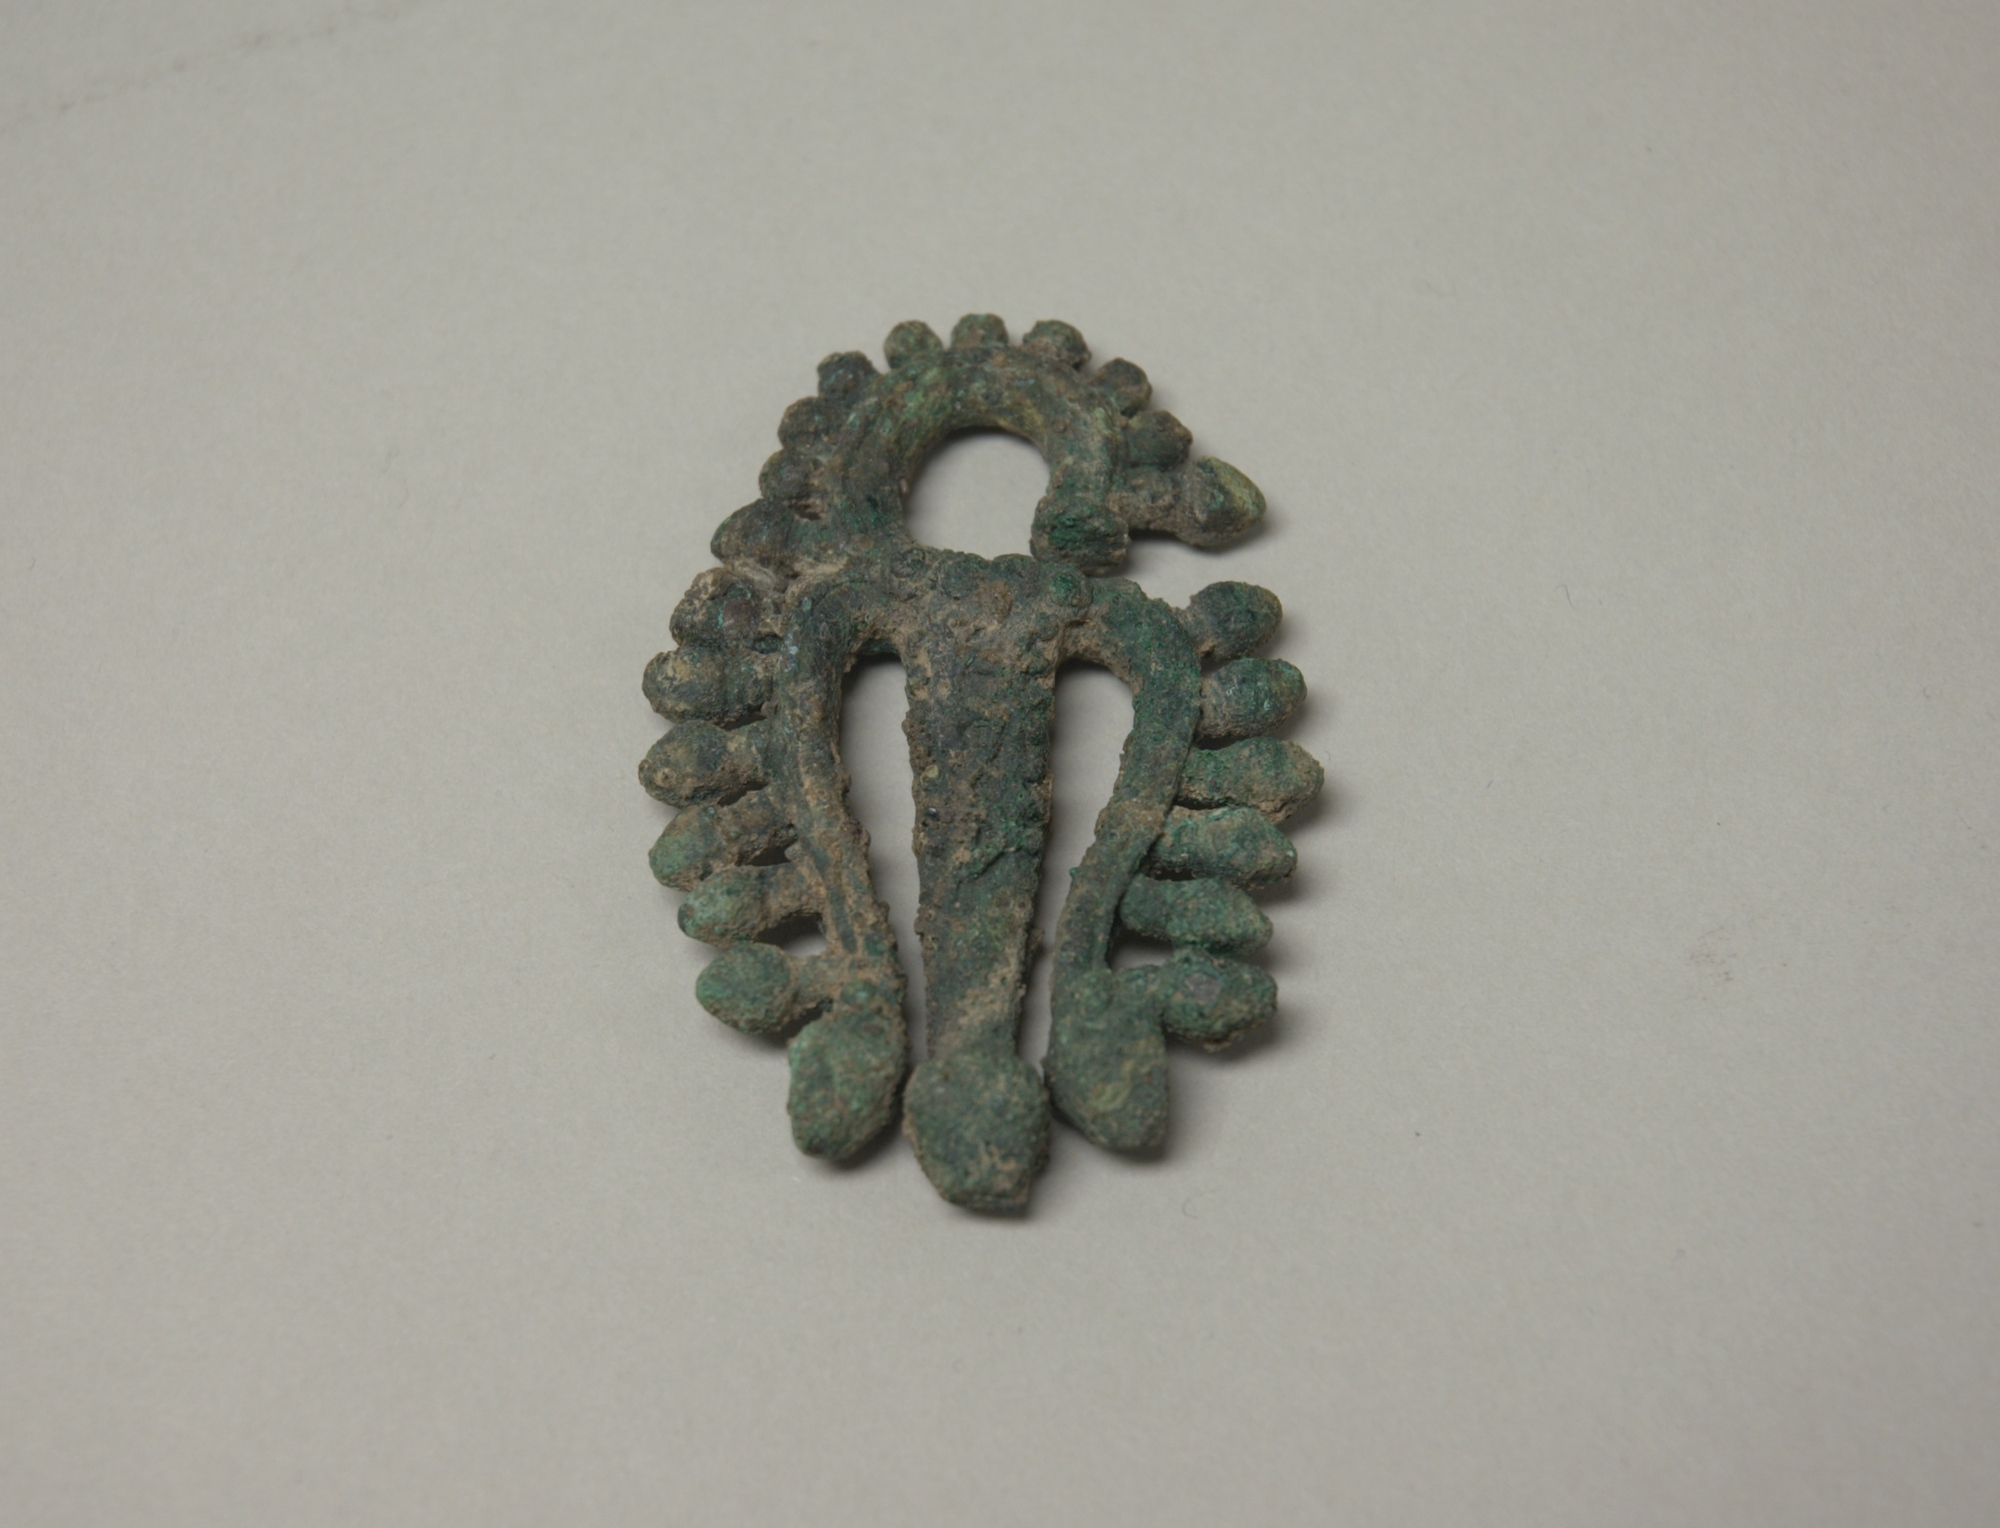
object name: earring with pendant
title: One of a Pair of Ear Pendants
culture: vietnamese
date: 500 BCE-300 CE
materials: bronze